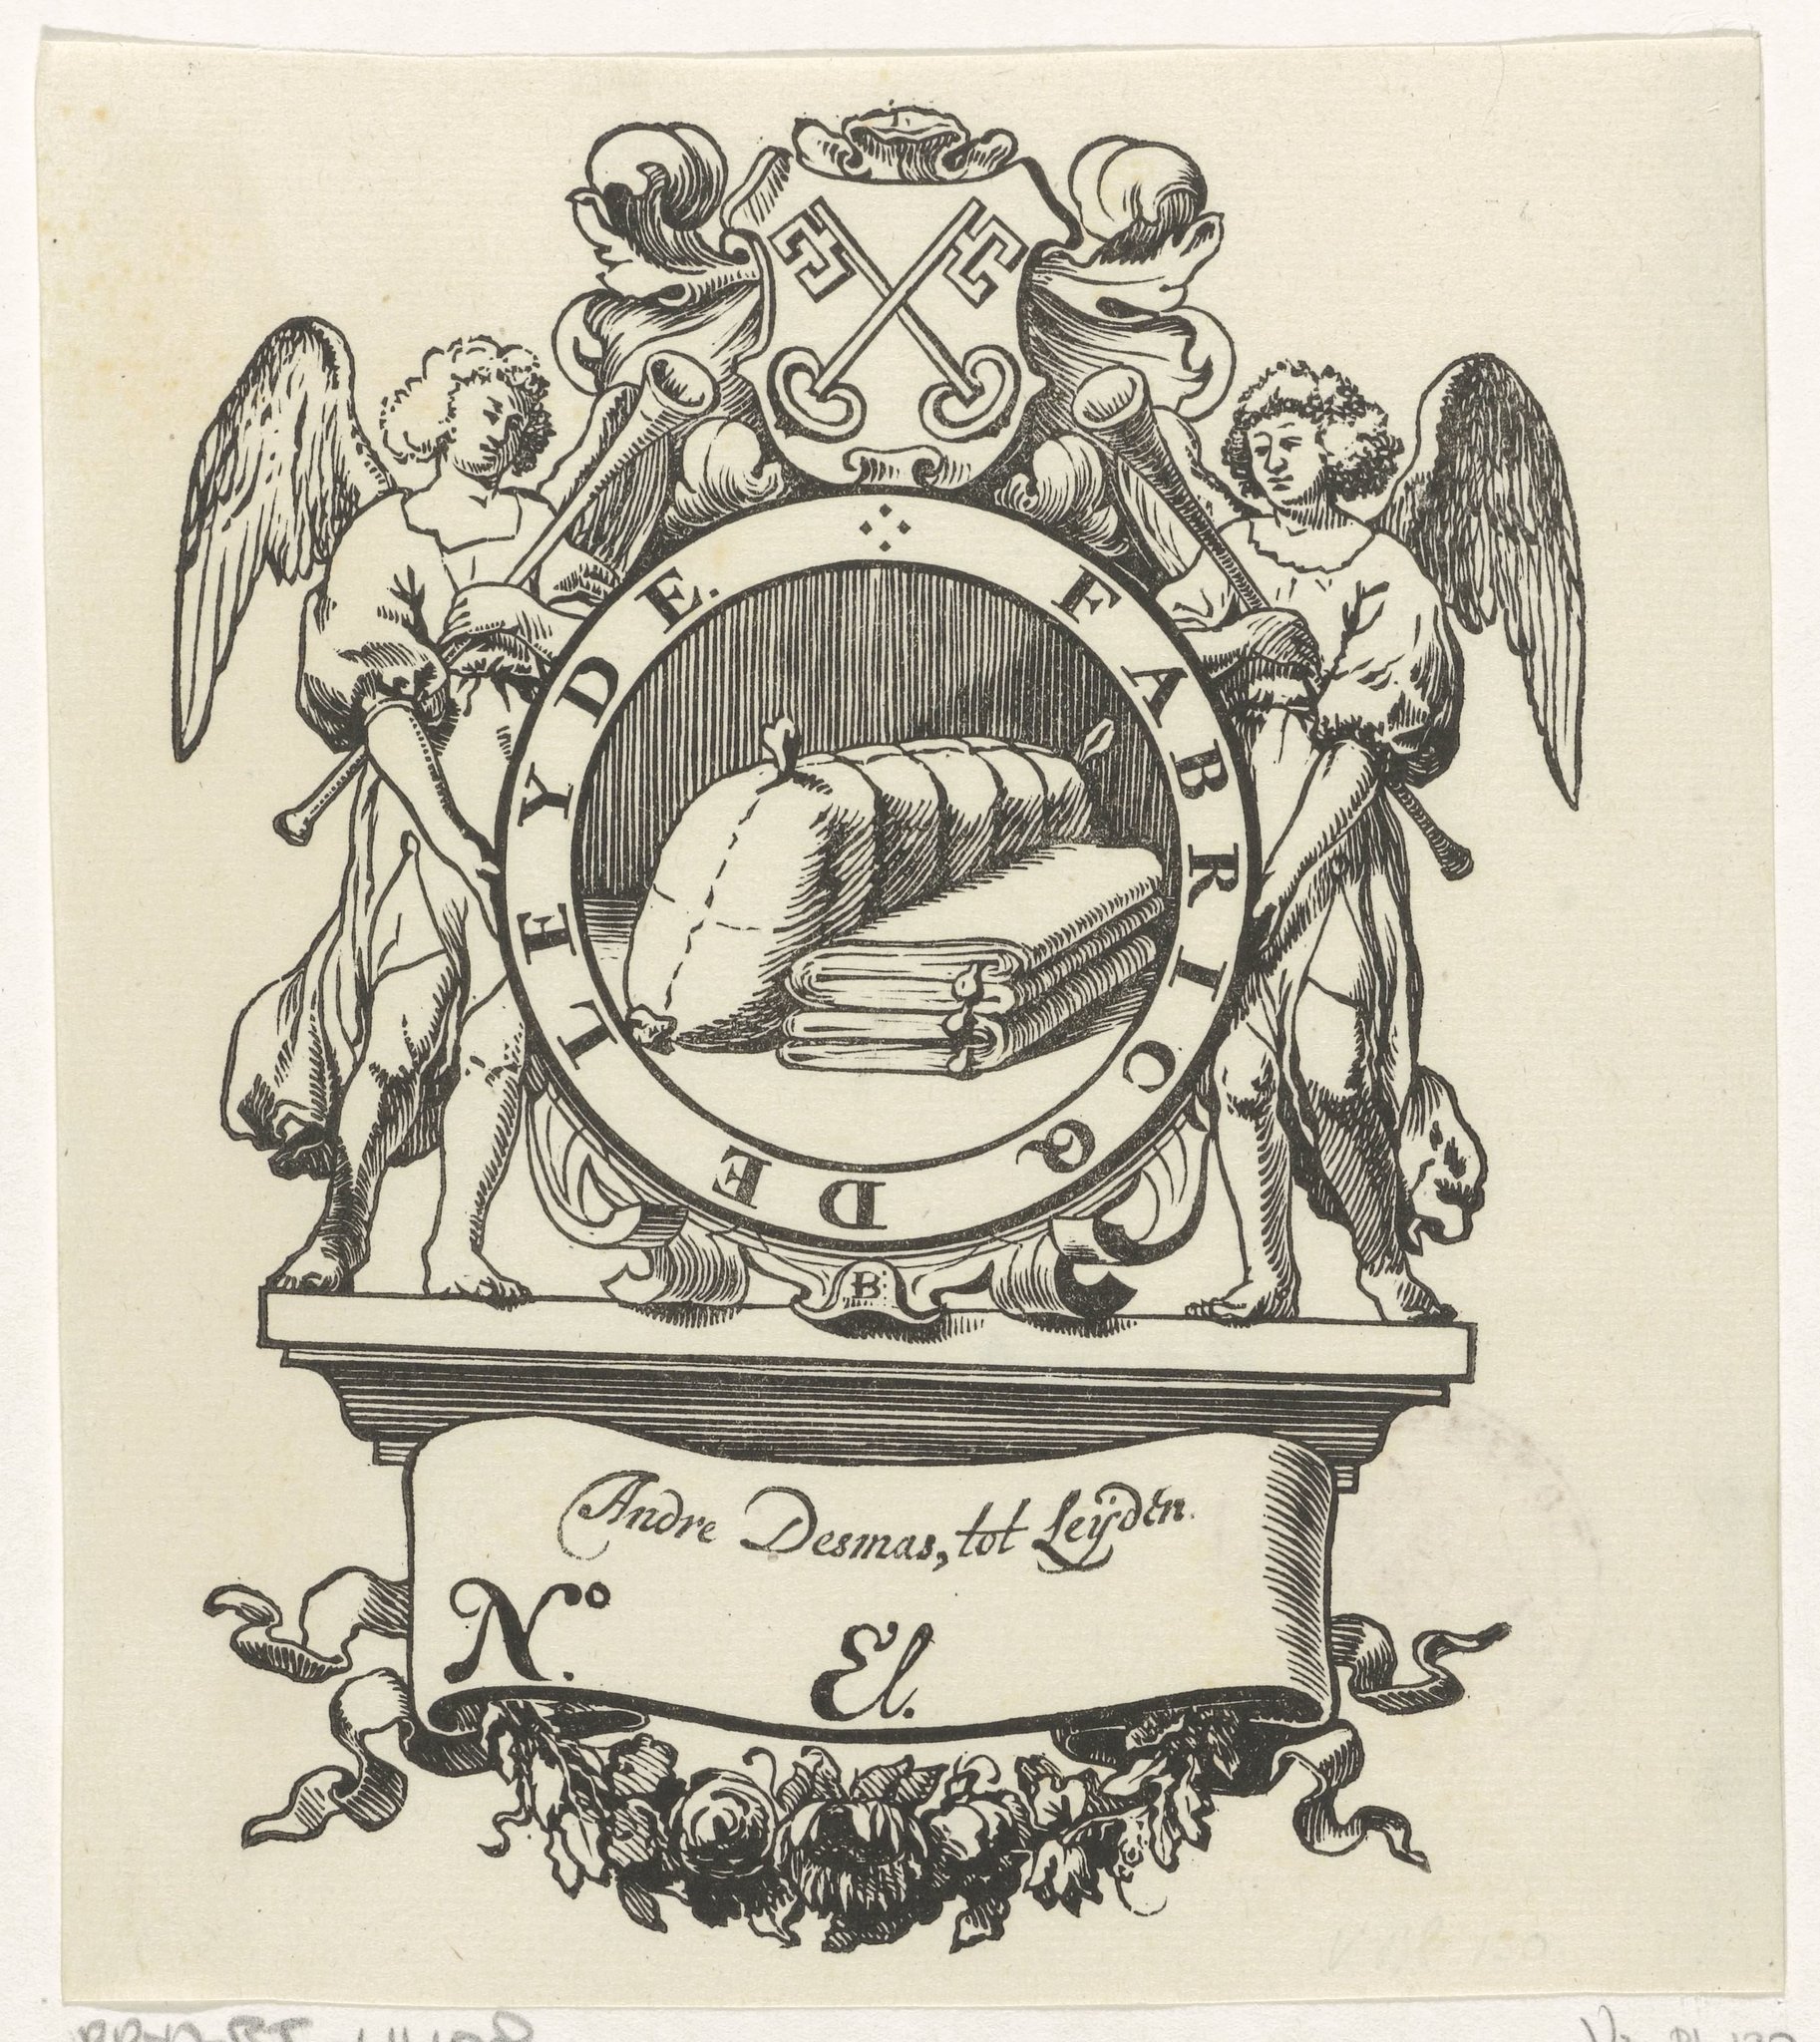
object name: print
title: Handelsmerk van de fabriek van André Desmas in Leiden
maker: dirck de bray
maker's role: draughtsman, painter, print maker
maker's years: 1625-1694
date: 1635-1694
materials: paper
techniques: woodcut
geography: netherlands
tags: factory-building, trade mark, trade token, trade sign, trade card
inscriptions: collector's mark: Lugt 240